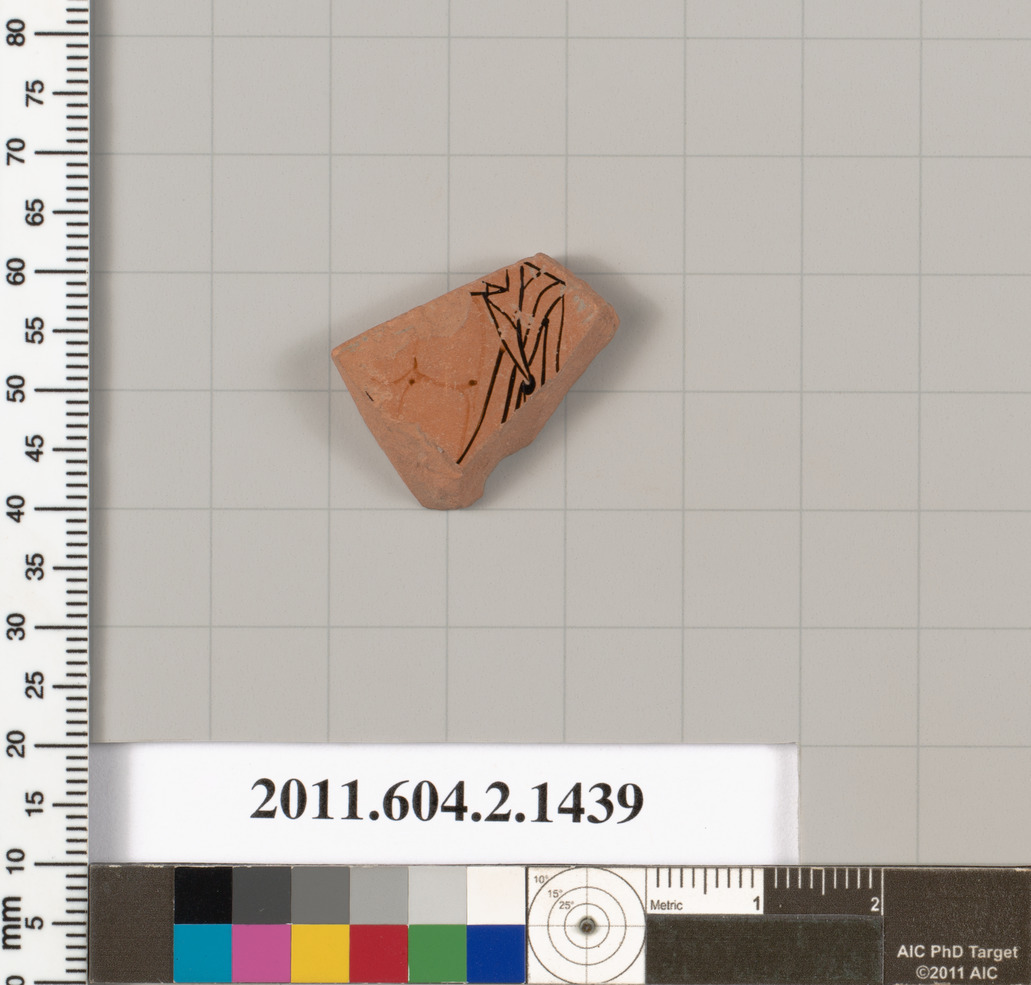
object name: skyphos fragment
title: Terracotta fragment of a skyphos (deep drinking cup)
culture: greek, attic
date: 490-470 BCE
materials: terracotta